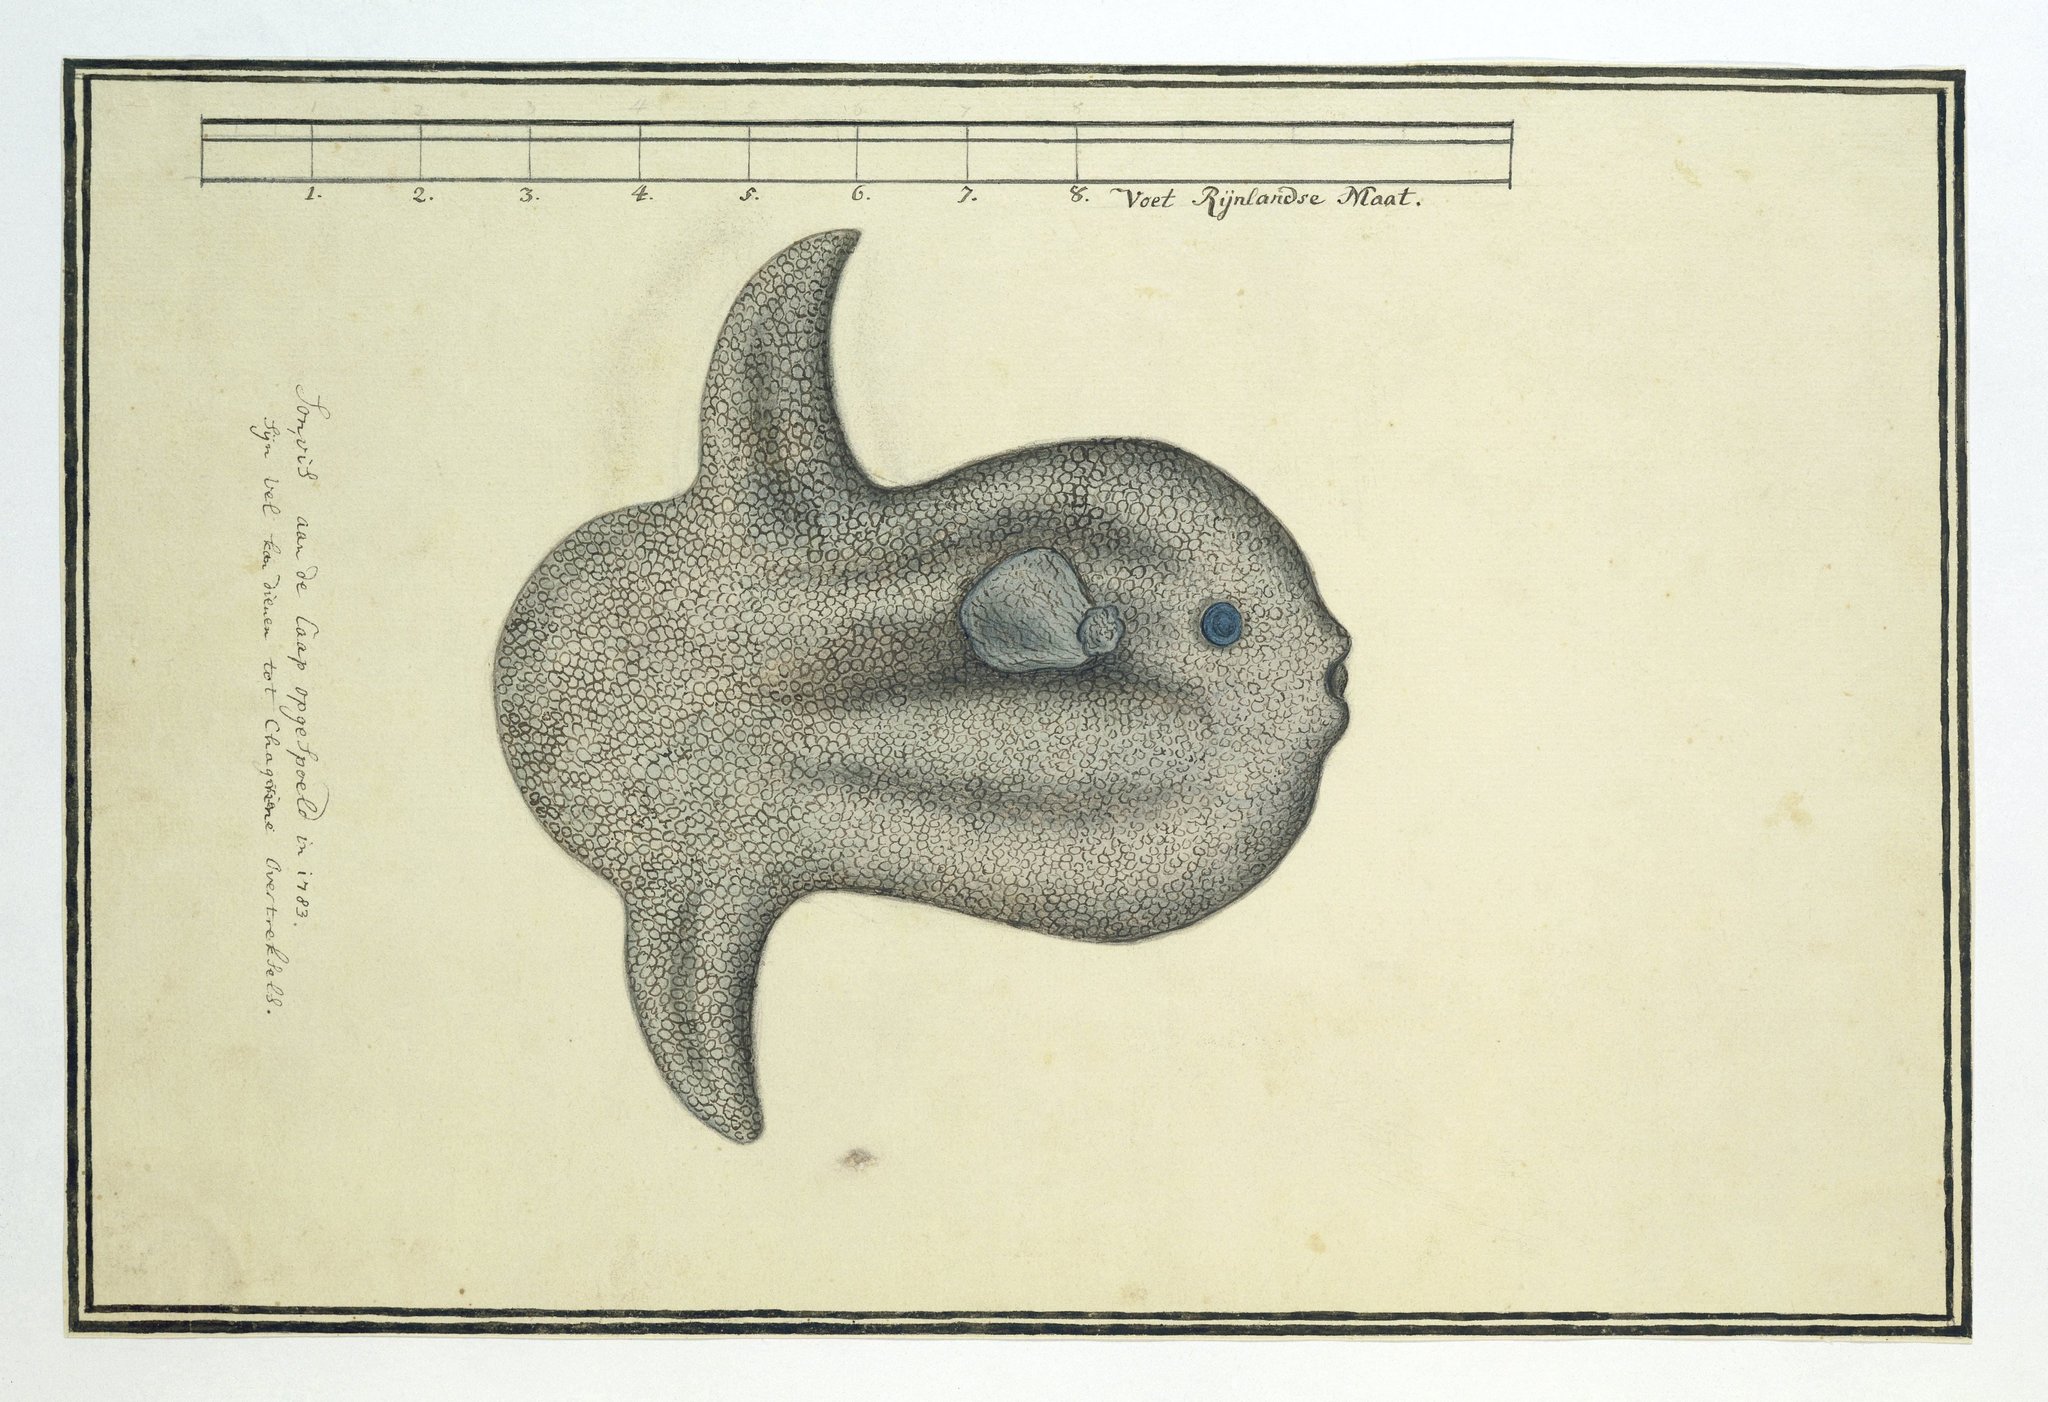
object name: dierstudie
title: Mola mola (Ocean sunfish)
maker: robert jacob gordon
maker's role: draughtsman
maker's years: 1743-1795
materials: chalk, ink, paper, pencil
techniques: brush, pen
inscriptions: annotation: ‘Sonvis aan de Caap opgespoeld in 1783. / sijn vel kan dienen tot Chagriene (sic) Overtreksels.’, annotation: ‘schaalverdeling met 'Voet Rijnlandse Maat. ' eronder geschreven’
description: Zonvis (mola mola); met schaalverdeling in Rijnlandse voet.